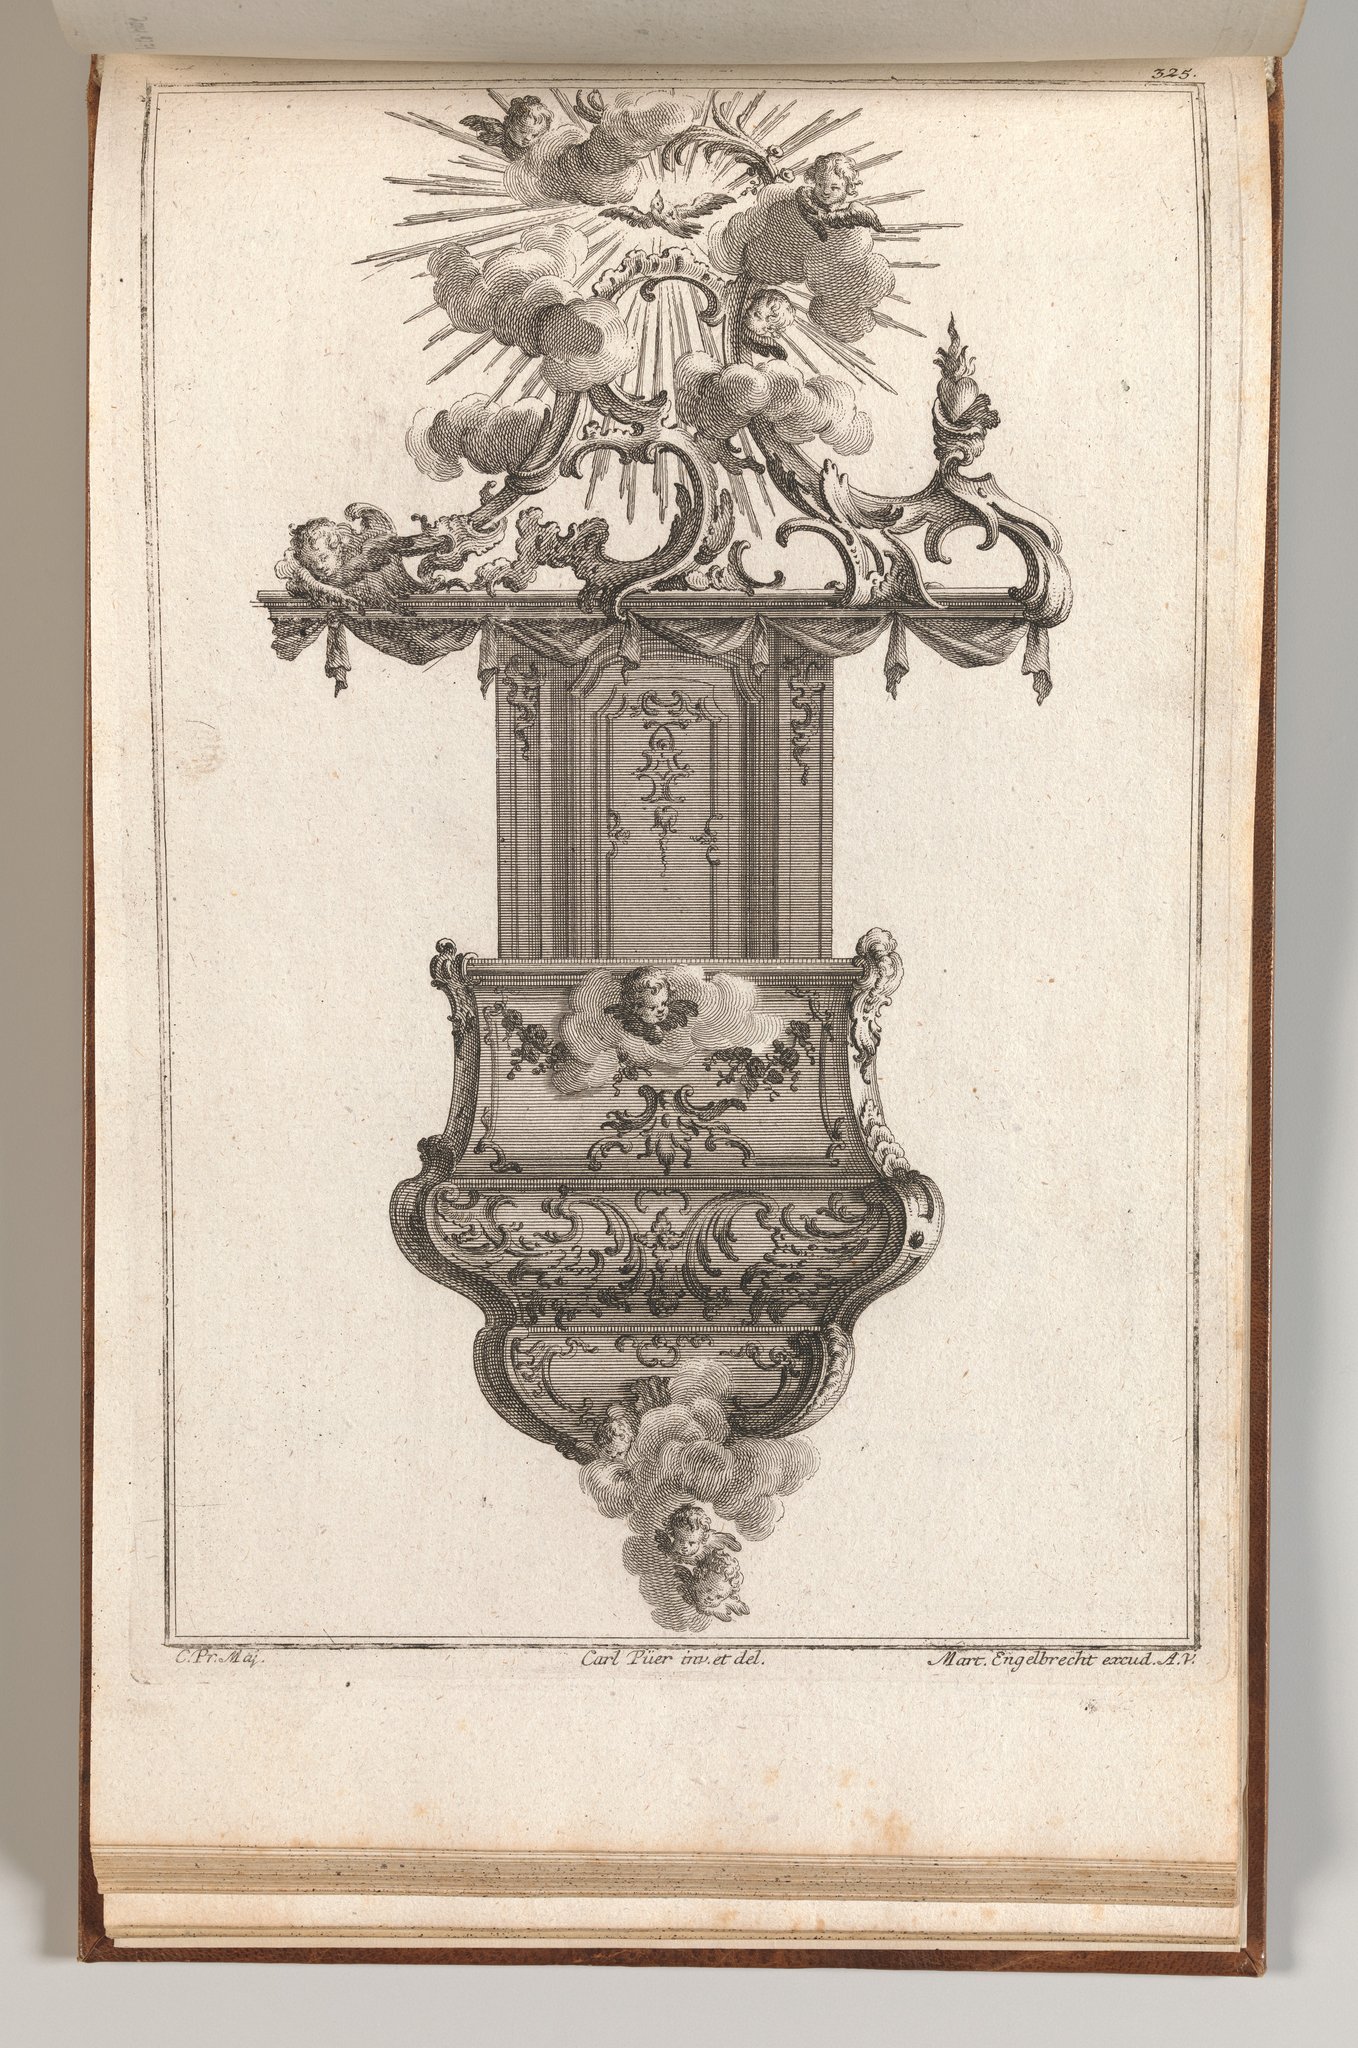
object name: album print ornament architecture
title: Design for a Pulpit, Plate 4 from an Untitled Series of Pulpit Designs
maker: carl pier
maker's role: artist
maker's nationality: german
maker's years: 1700-1790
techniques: etching